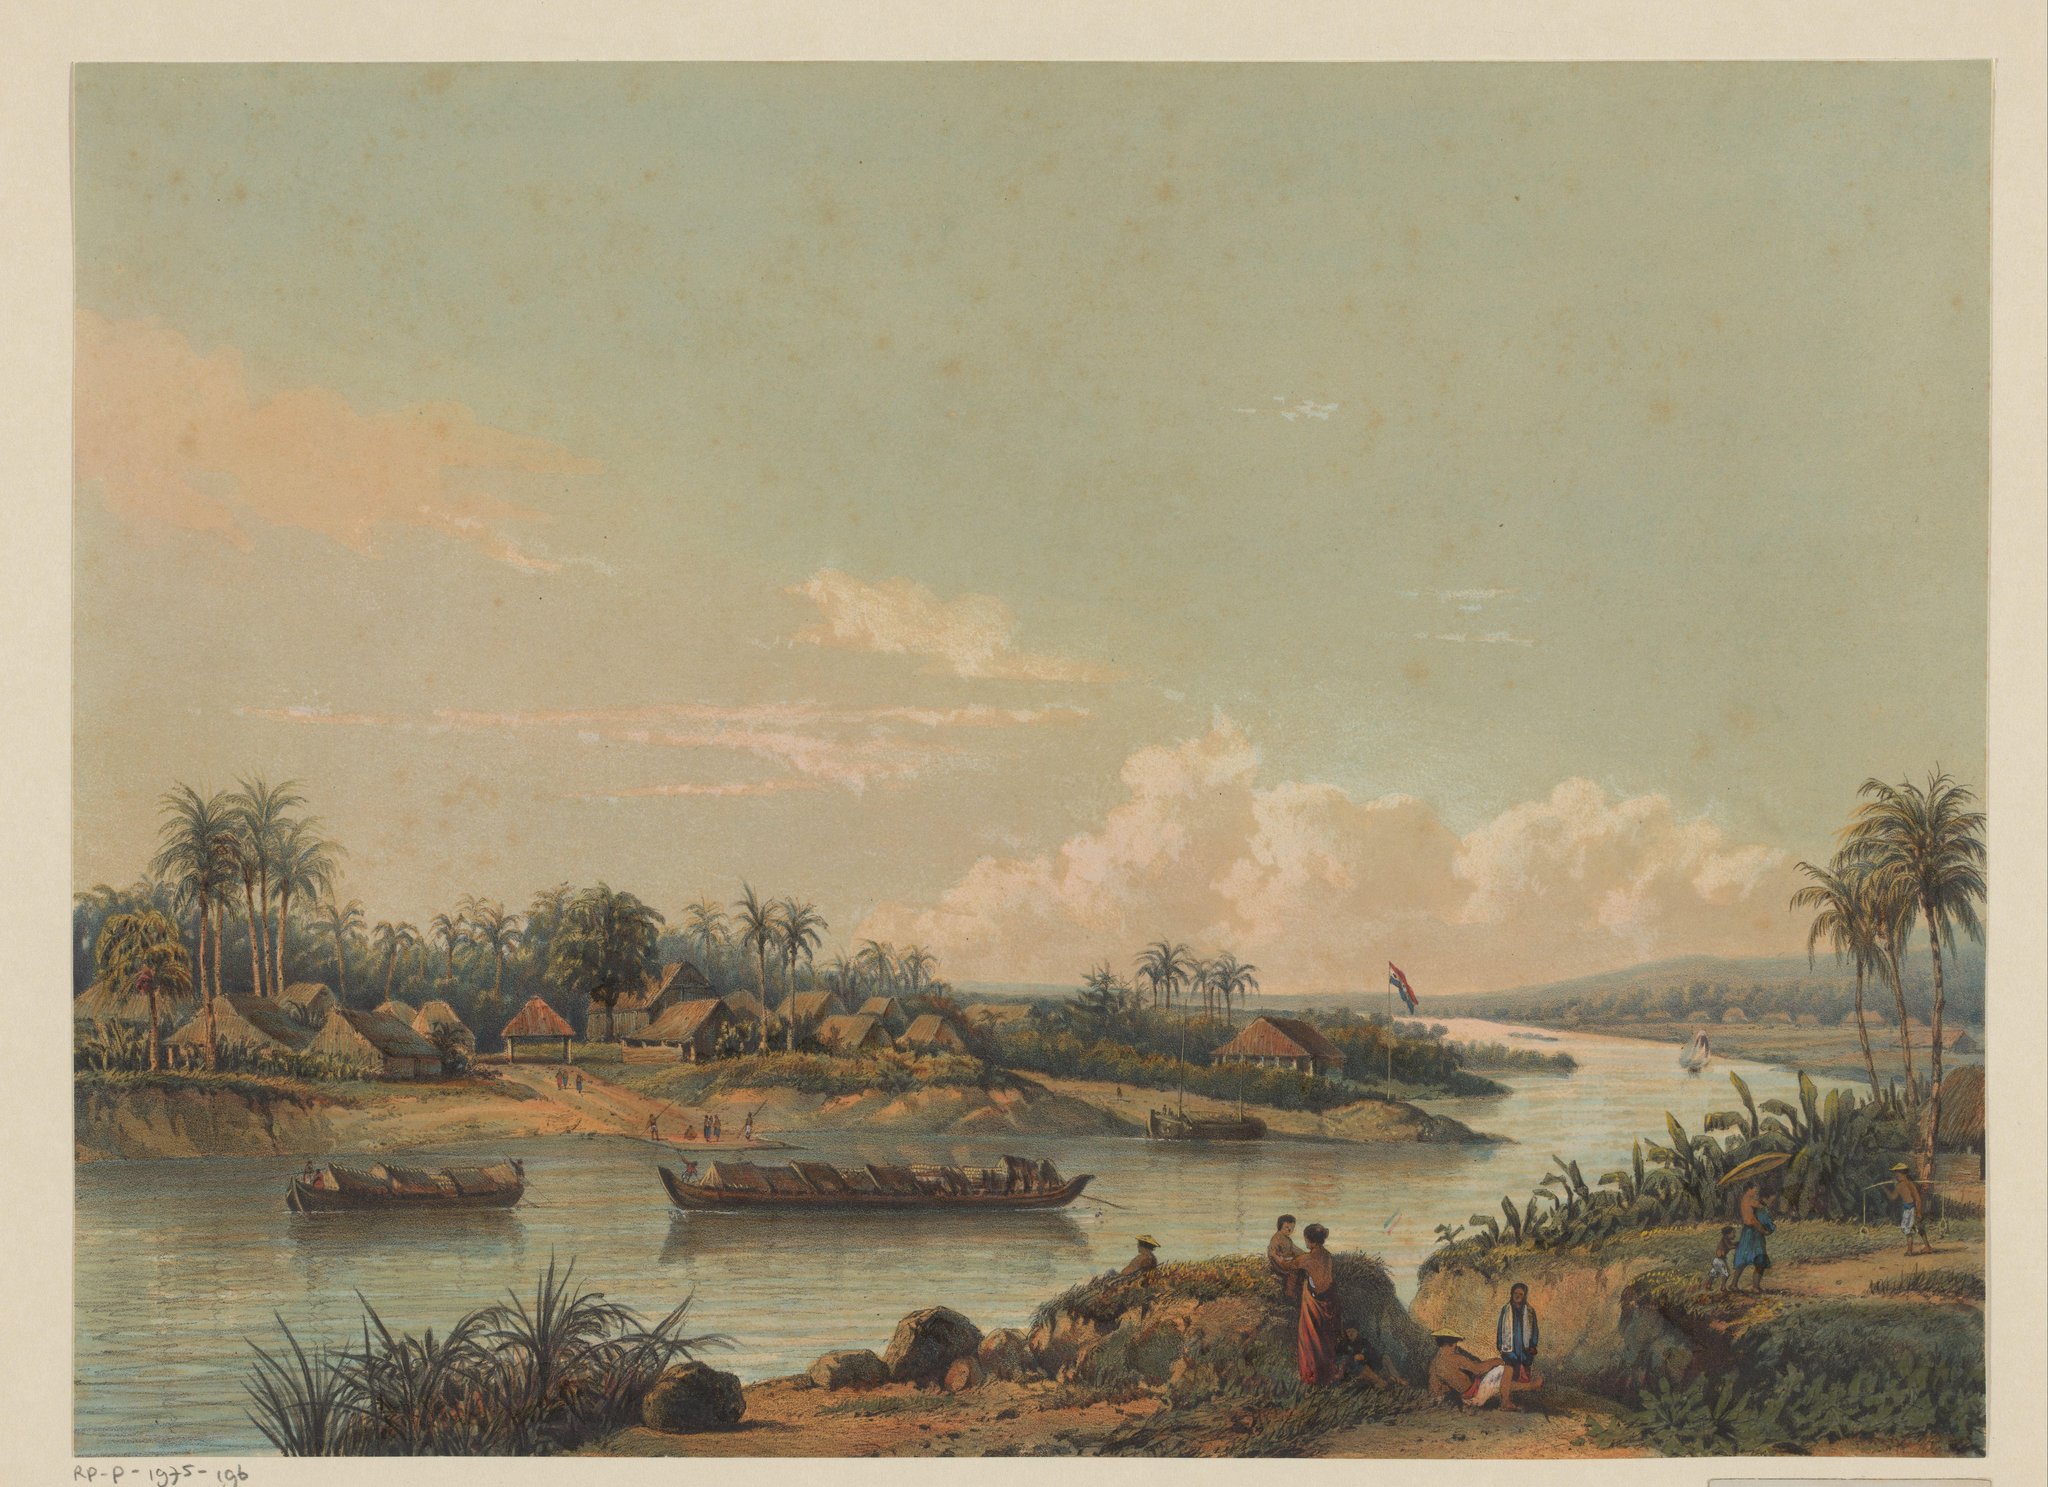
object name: print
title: Gezicht op de rivier de solo (afdeeling Toeban, residentie Rembang.)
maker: johan conrad greive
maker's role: draughtsman, painter, print maker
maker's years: 1837-1891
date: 1869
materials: paper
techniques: lithograph, hand coloring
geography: amsterdam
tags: landscapes in tropical and sub-tropical regions, river (+ landscape with figures, staffage), java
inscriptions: collector's mark: Lugt 2228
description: Op het water varen twee boten. Op de linkeroever ligt een dorp, rechts figuren. De prent maakt deel uit van een omslag met een tekstblad en 24 losse prenten.